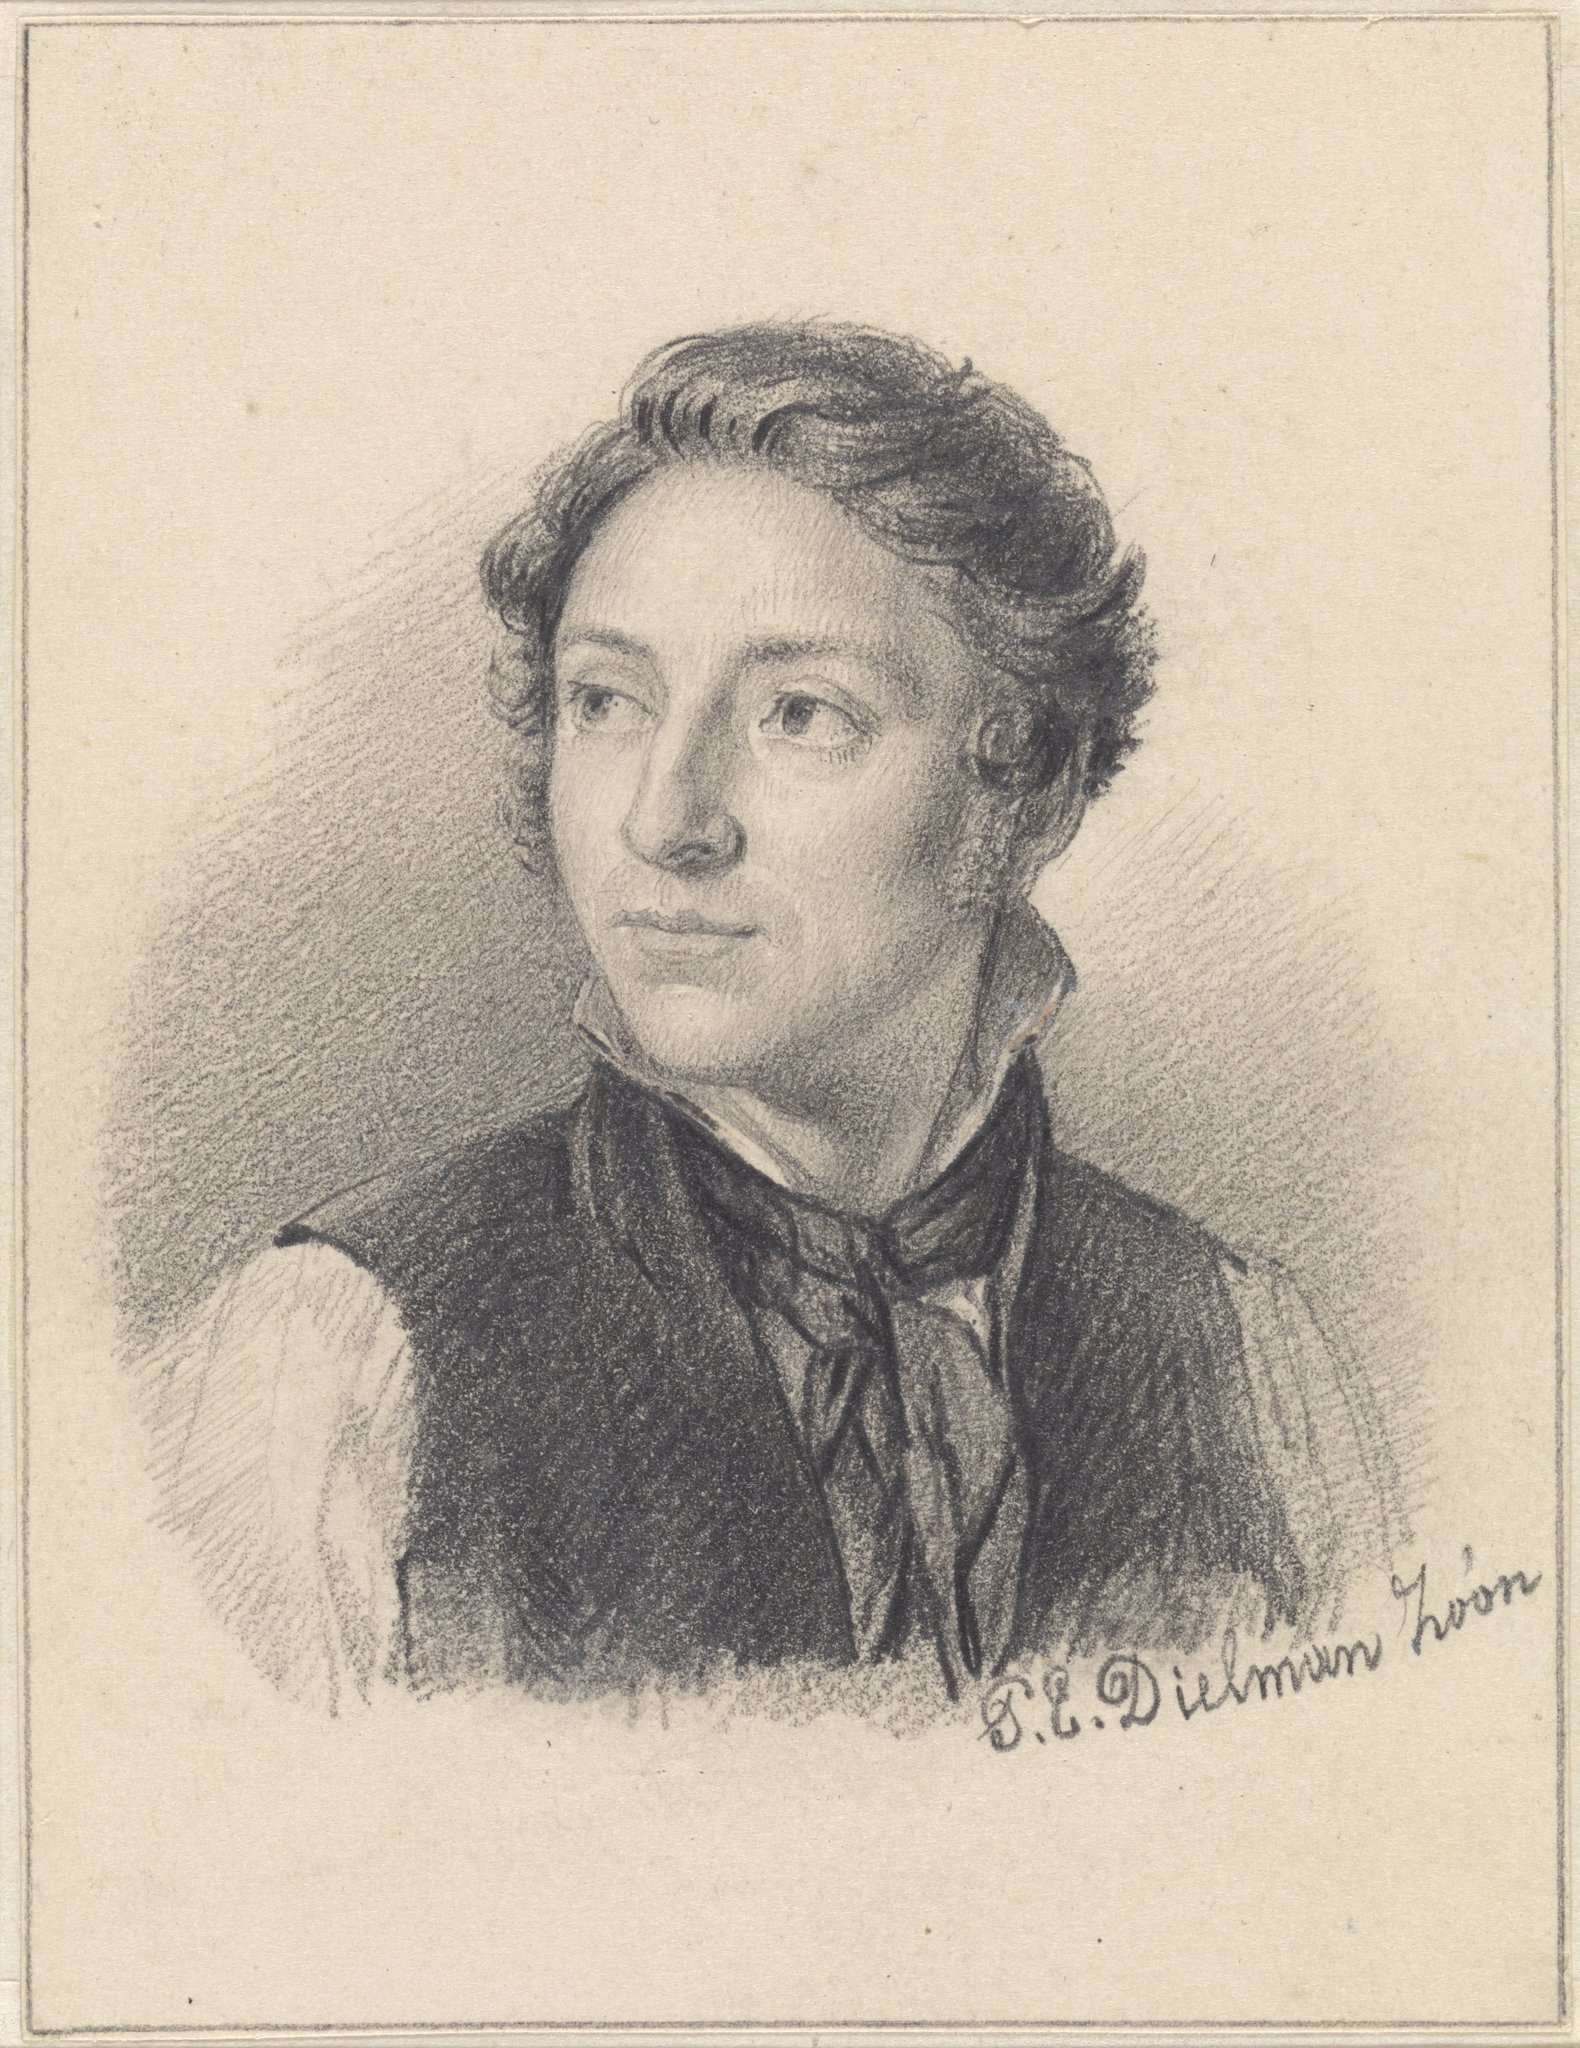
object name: drawing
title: Zelfportret van Petrus Emanuel Dielman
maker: pierre emmanuel dielman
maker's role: draughtsman, painter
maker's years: 1800-1858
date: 1810-1858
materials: paper, pencil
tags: ghent, den bosch, painter, draughtsman, pierre emmanuel dielman, historical persons, portrait, self-portrait of painter, portrait, self-portrait of artist, portrait, self-portrait of draughtsman